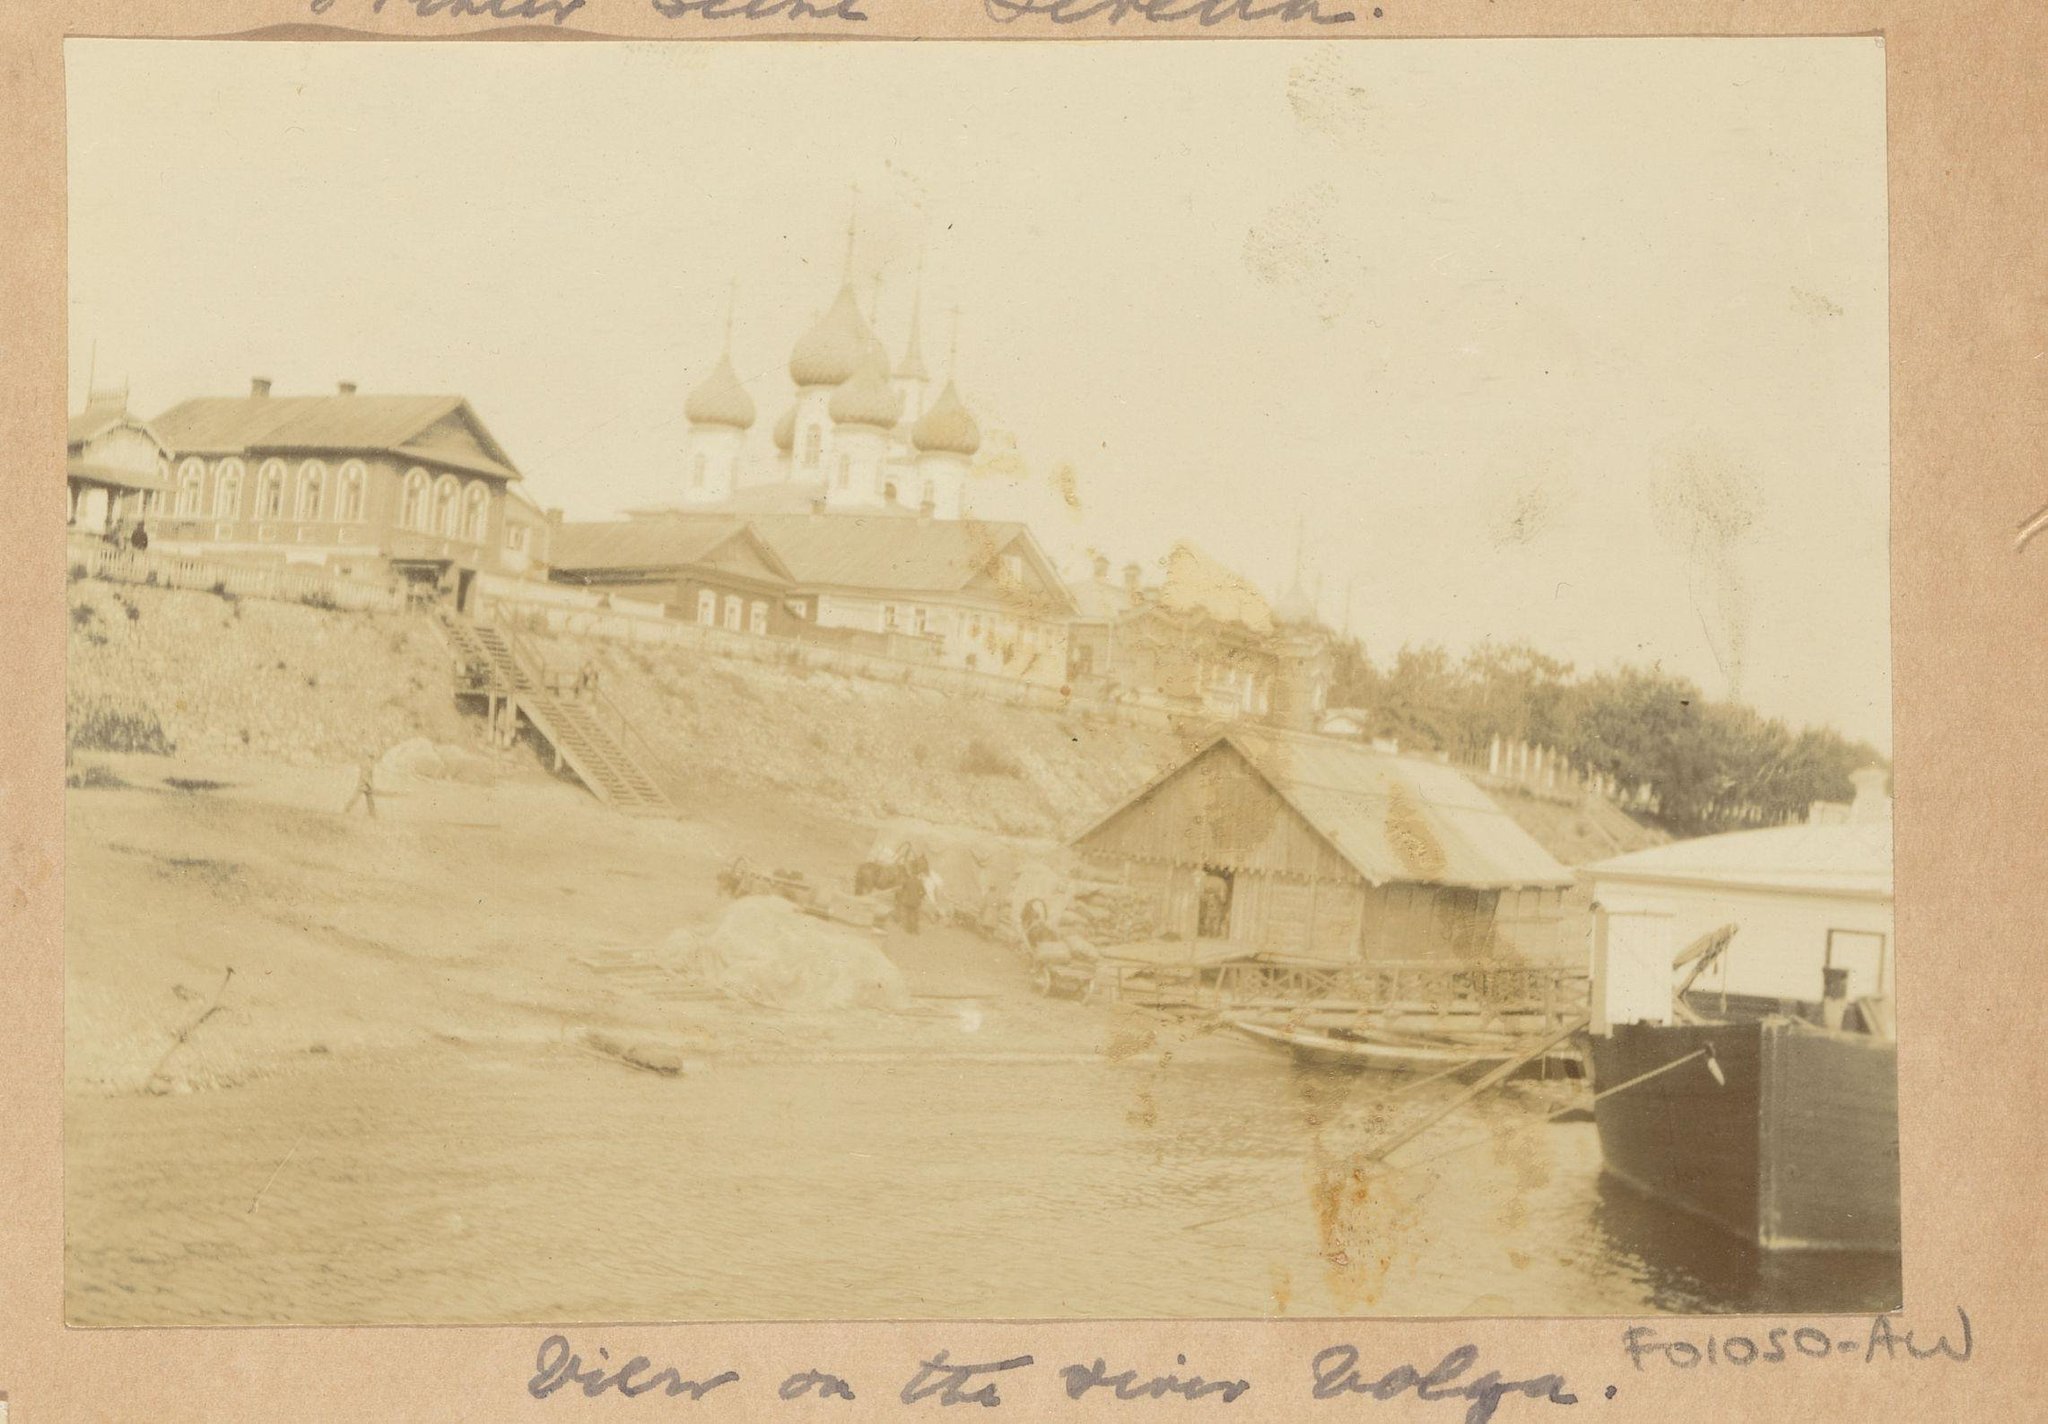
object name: photograph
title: Gezicht op kerk en gebouwen aan de oever van de Wolga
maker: joseph cheetham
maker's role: engineer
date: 1903-1904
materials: photographic support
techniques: gelatin silver print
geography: russia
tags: river bank, church (exterior)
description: Onderdeel van Fotoalbum van de Engelse familie Cheetham met opnames van hun verblijf in Rusland.